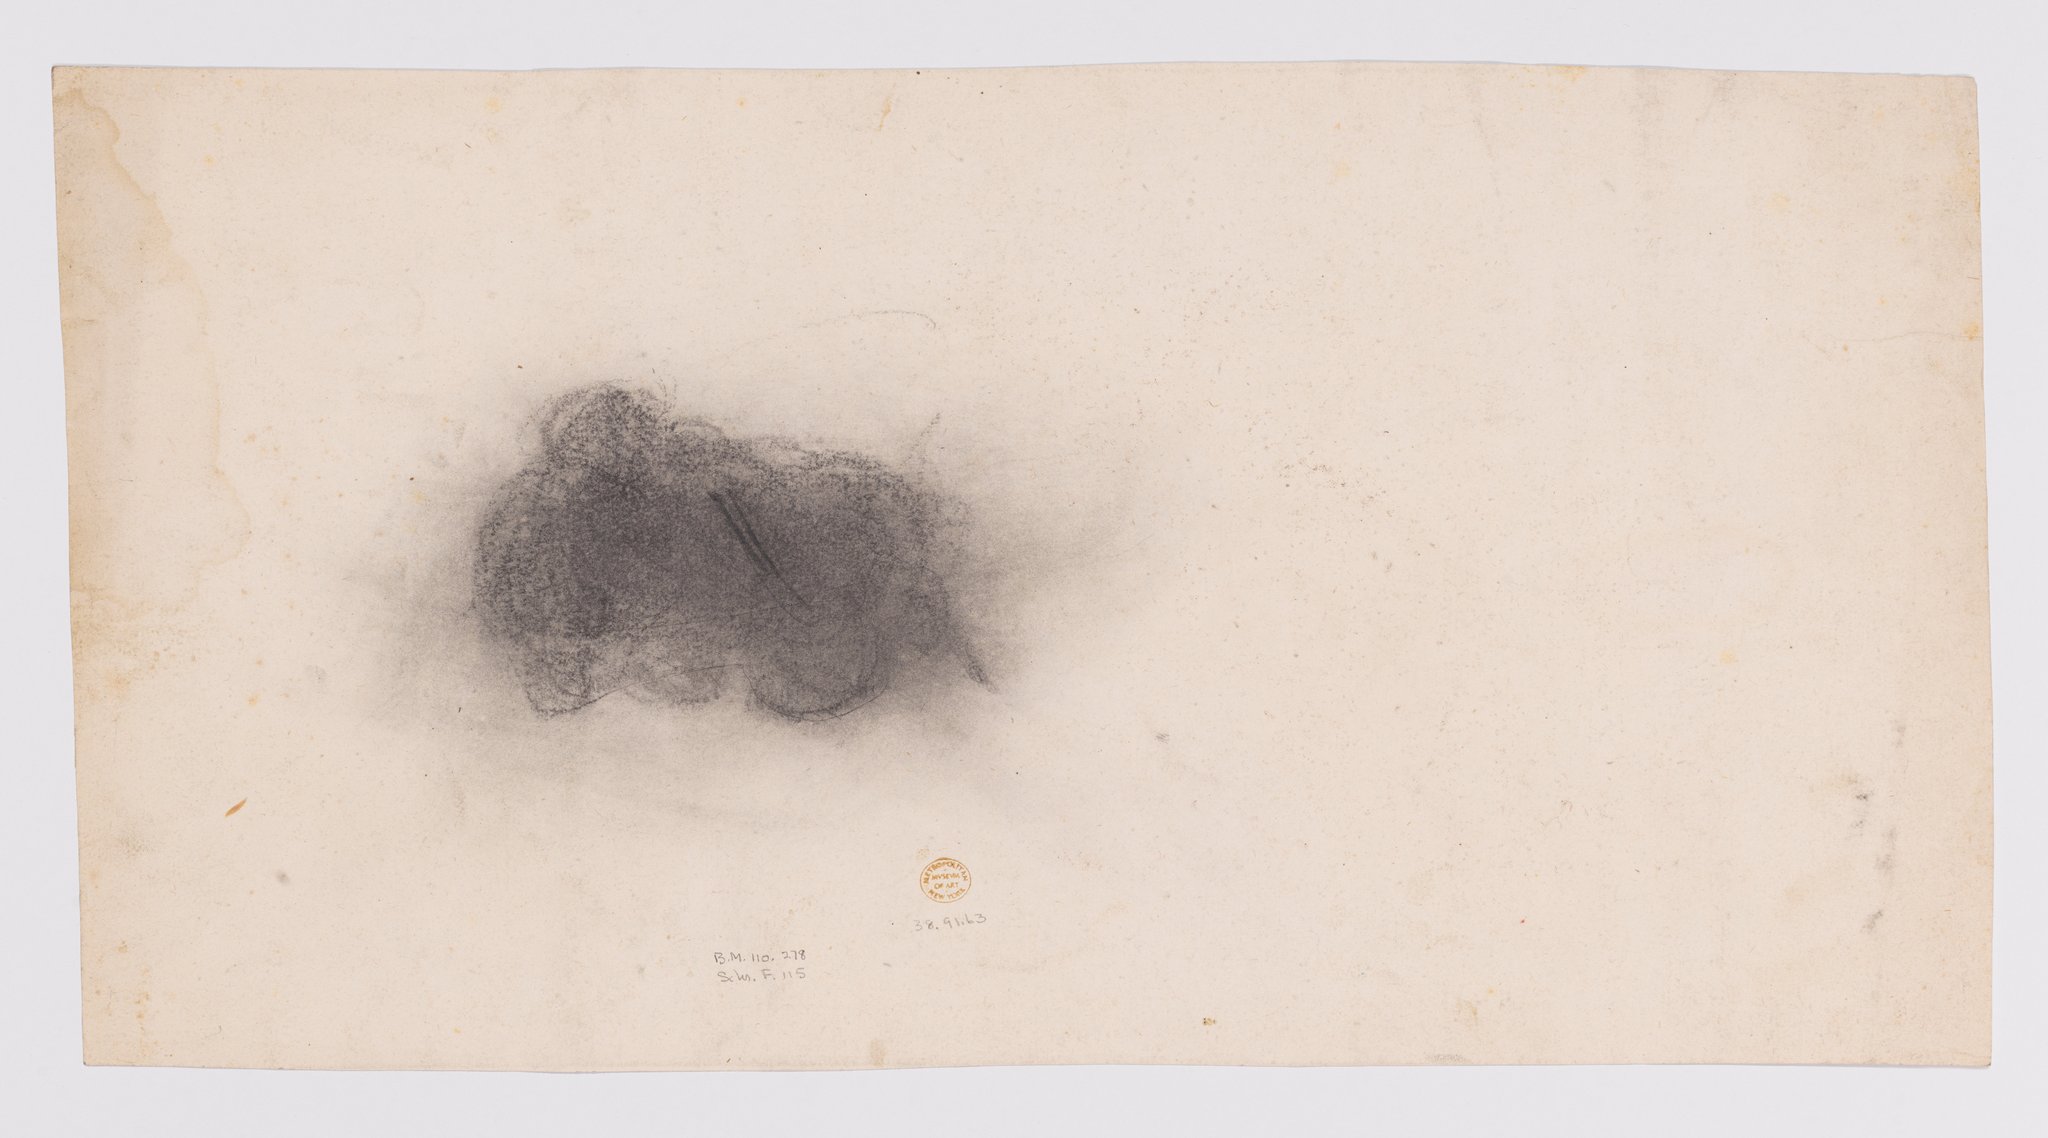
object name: print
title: Fan leaf of Aurora after the fresco by Guercino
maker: guercino (giovanni francesco barbieri)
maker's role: artist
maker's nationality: italian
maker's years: 1591-1666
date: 1796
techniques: engraving, etching